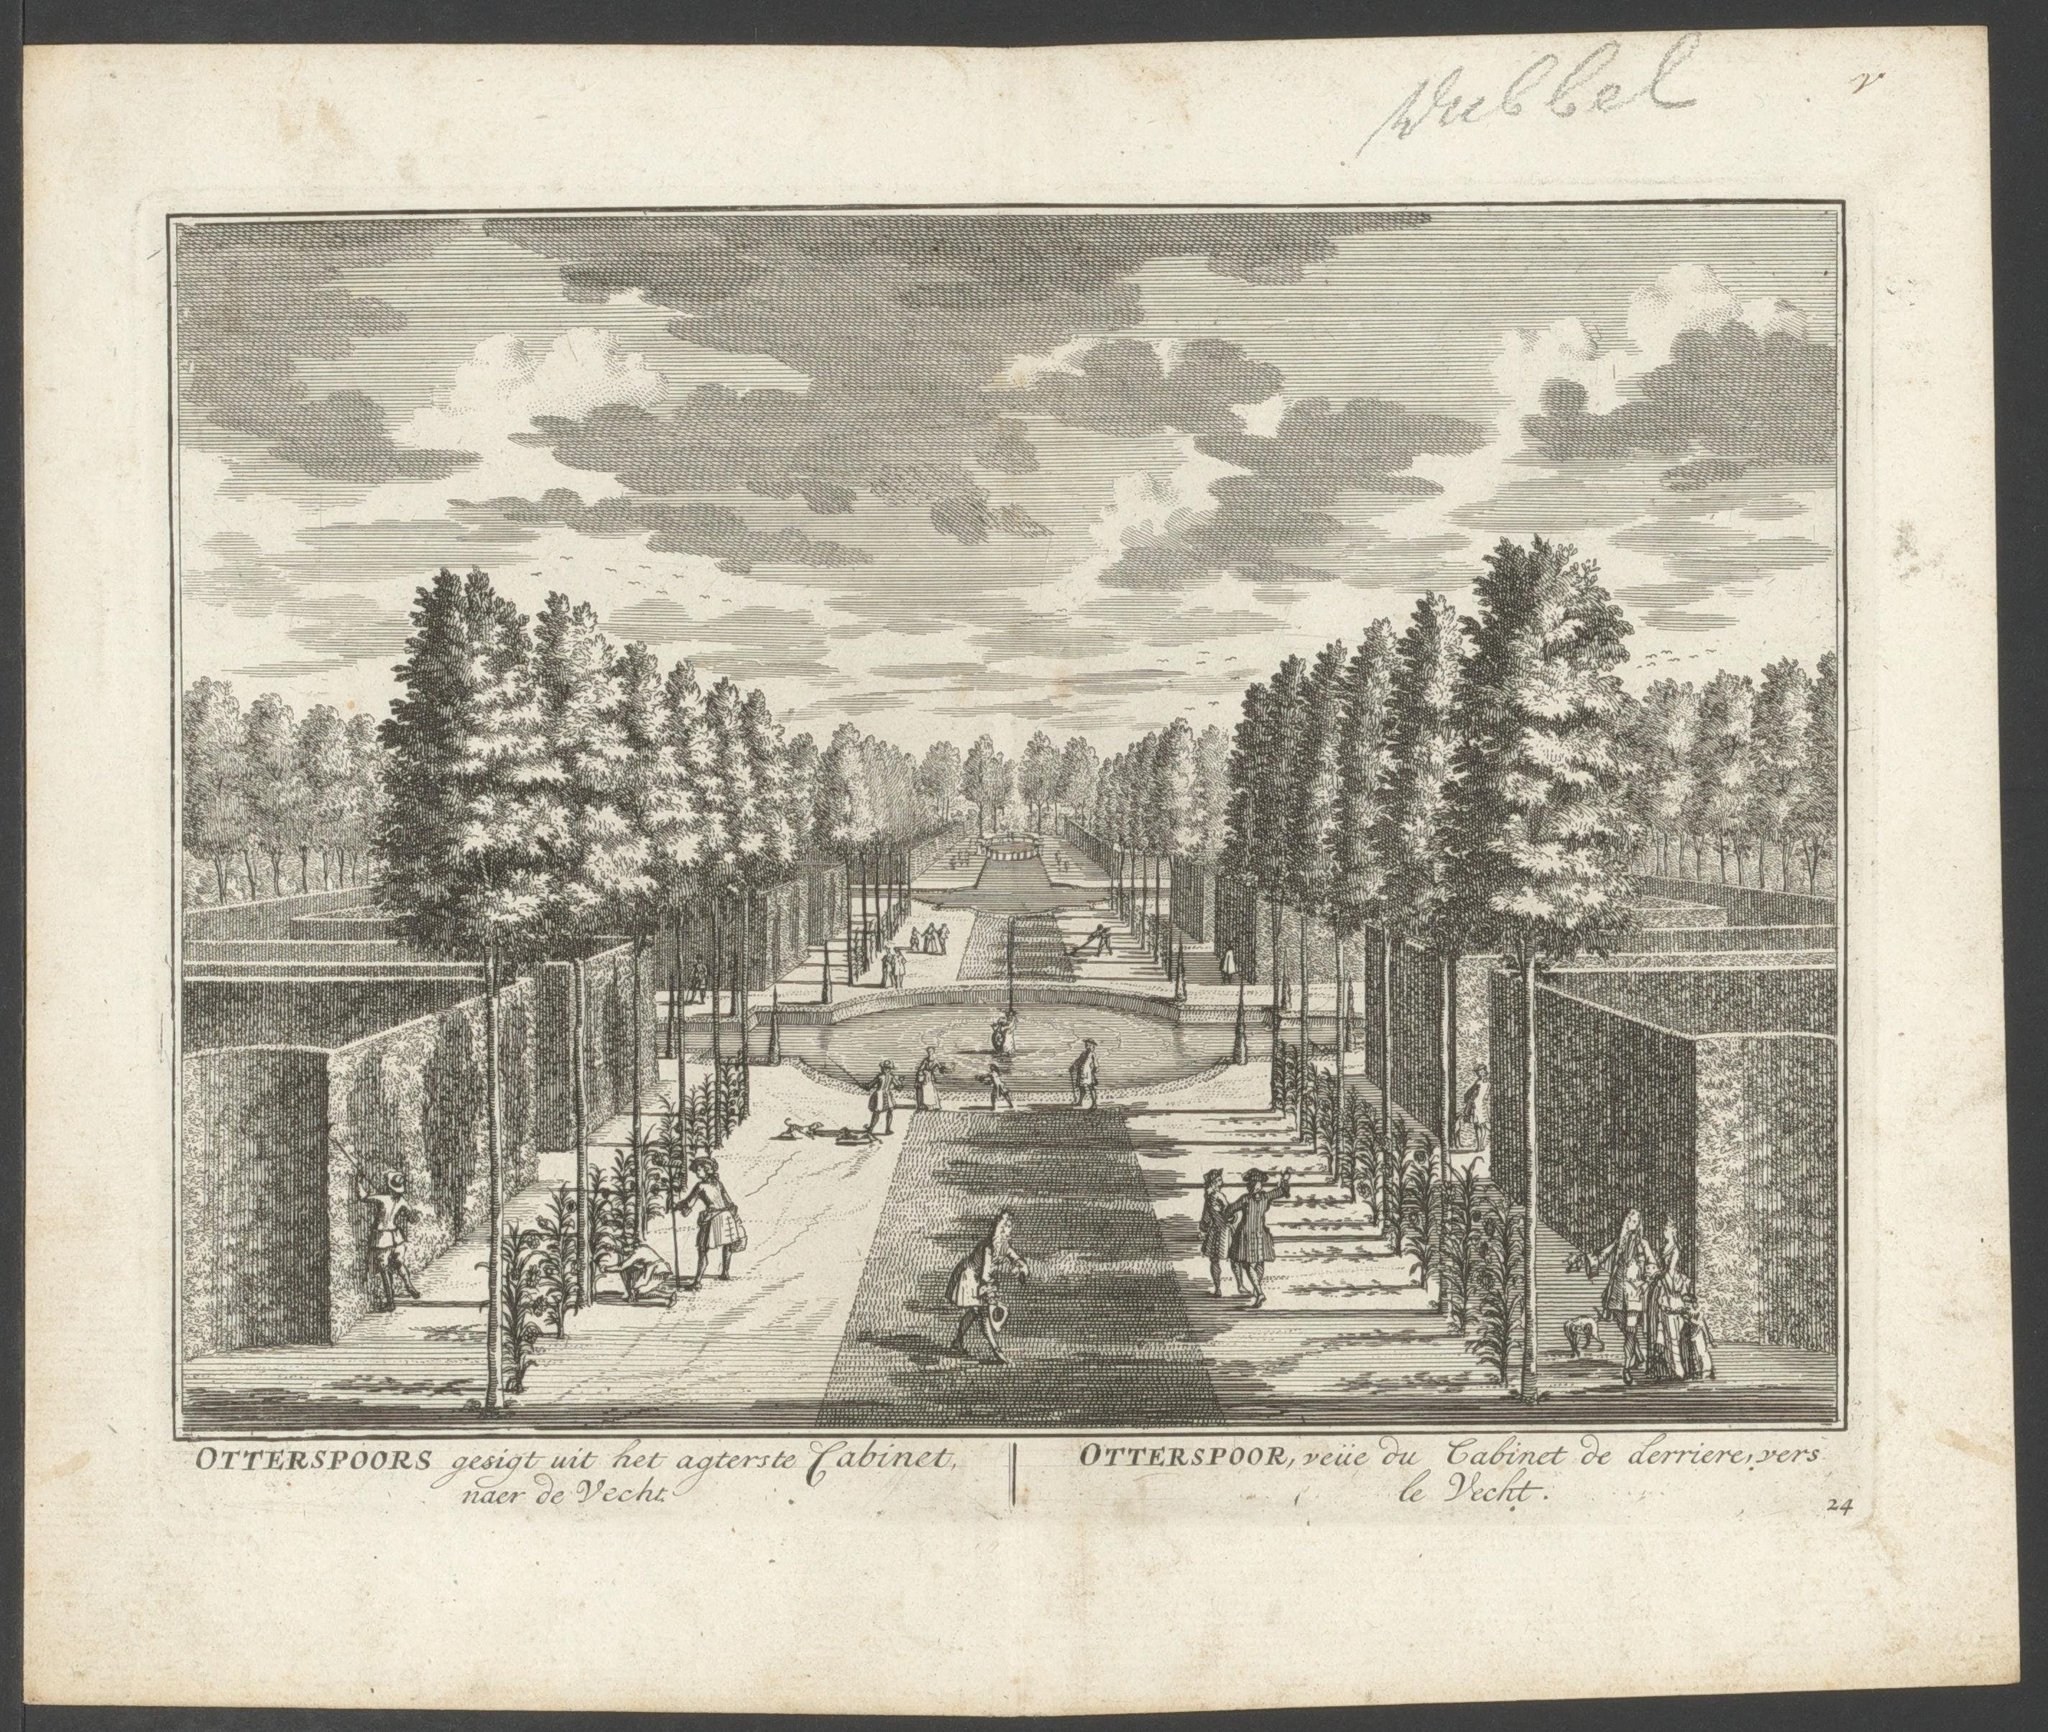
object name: print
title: Gezicht op de tuin van buitenplaats Otterspoor aan de Vecht bij Maarssen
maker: daniël stopendaal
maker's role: print maker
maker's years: 1672-1726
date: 1719-1790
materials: paper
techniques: engraving, etching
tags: french or architectonic garden; formal garden, garden pond, maarssen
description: Prent voor het eerst gebruikt in: Leth, Andries de. De zegepraalende Vecht, vertoonende verscheidene gesichten van lustplaatsen, heeren huysen en dorpen, beginnende van Uitrecht en met Muyden besluytende (...). Amsterdam: Weduwe Nicolaus Visscher, 1719. Prent mogelijk uit: Brouërius van Nidek, Matthaeus. De Vechtstroom, van Utrecht tot Muiden (...). Amsterdam: H. Gartman, W. Vermandel en J.W. Smit, 1790.